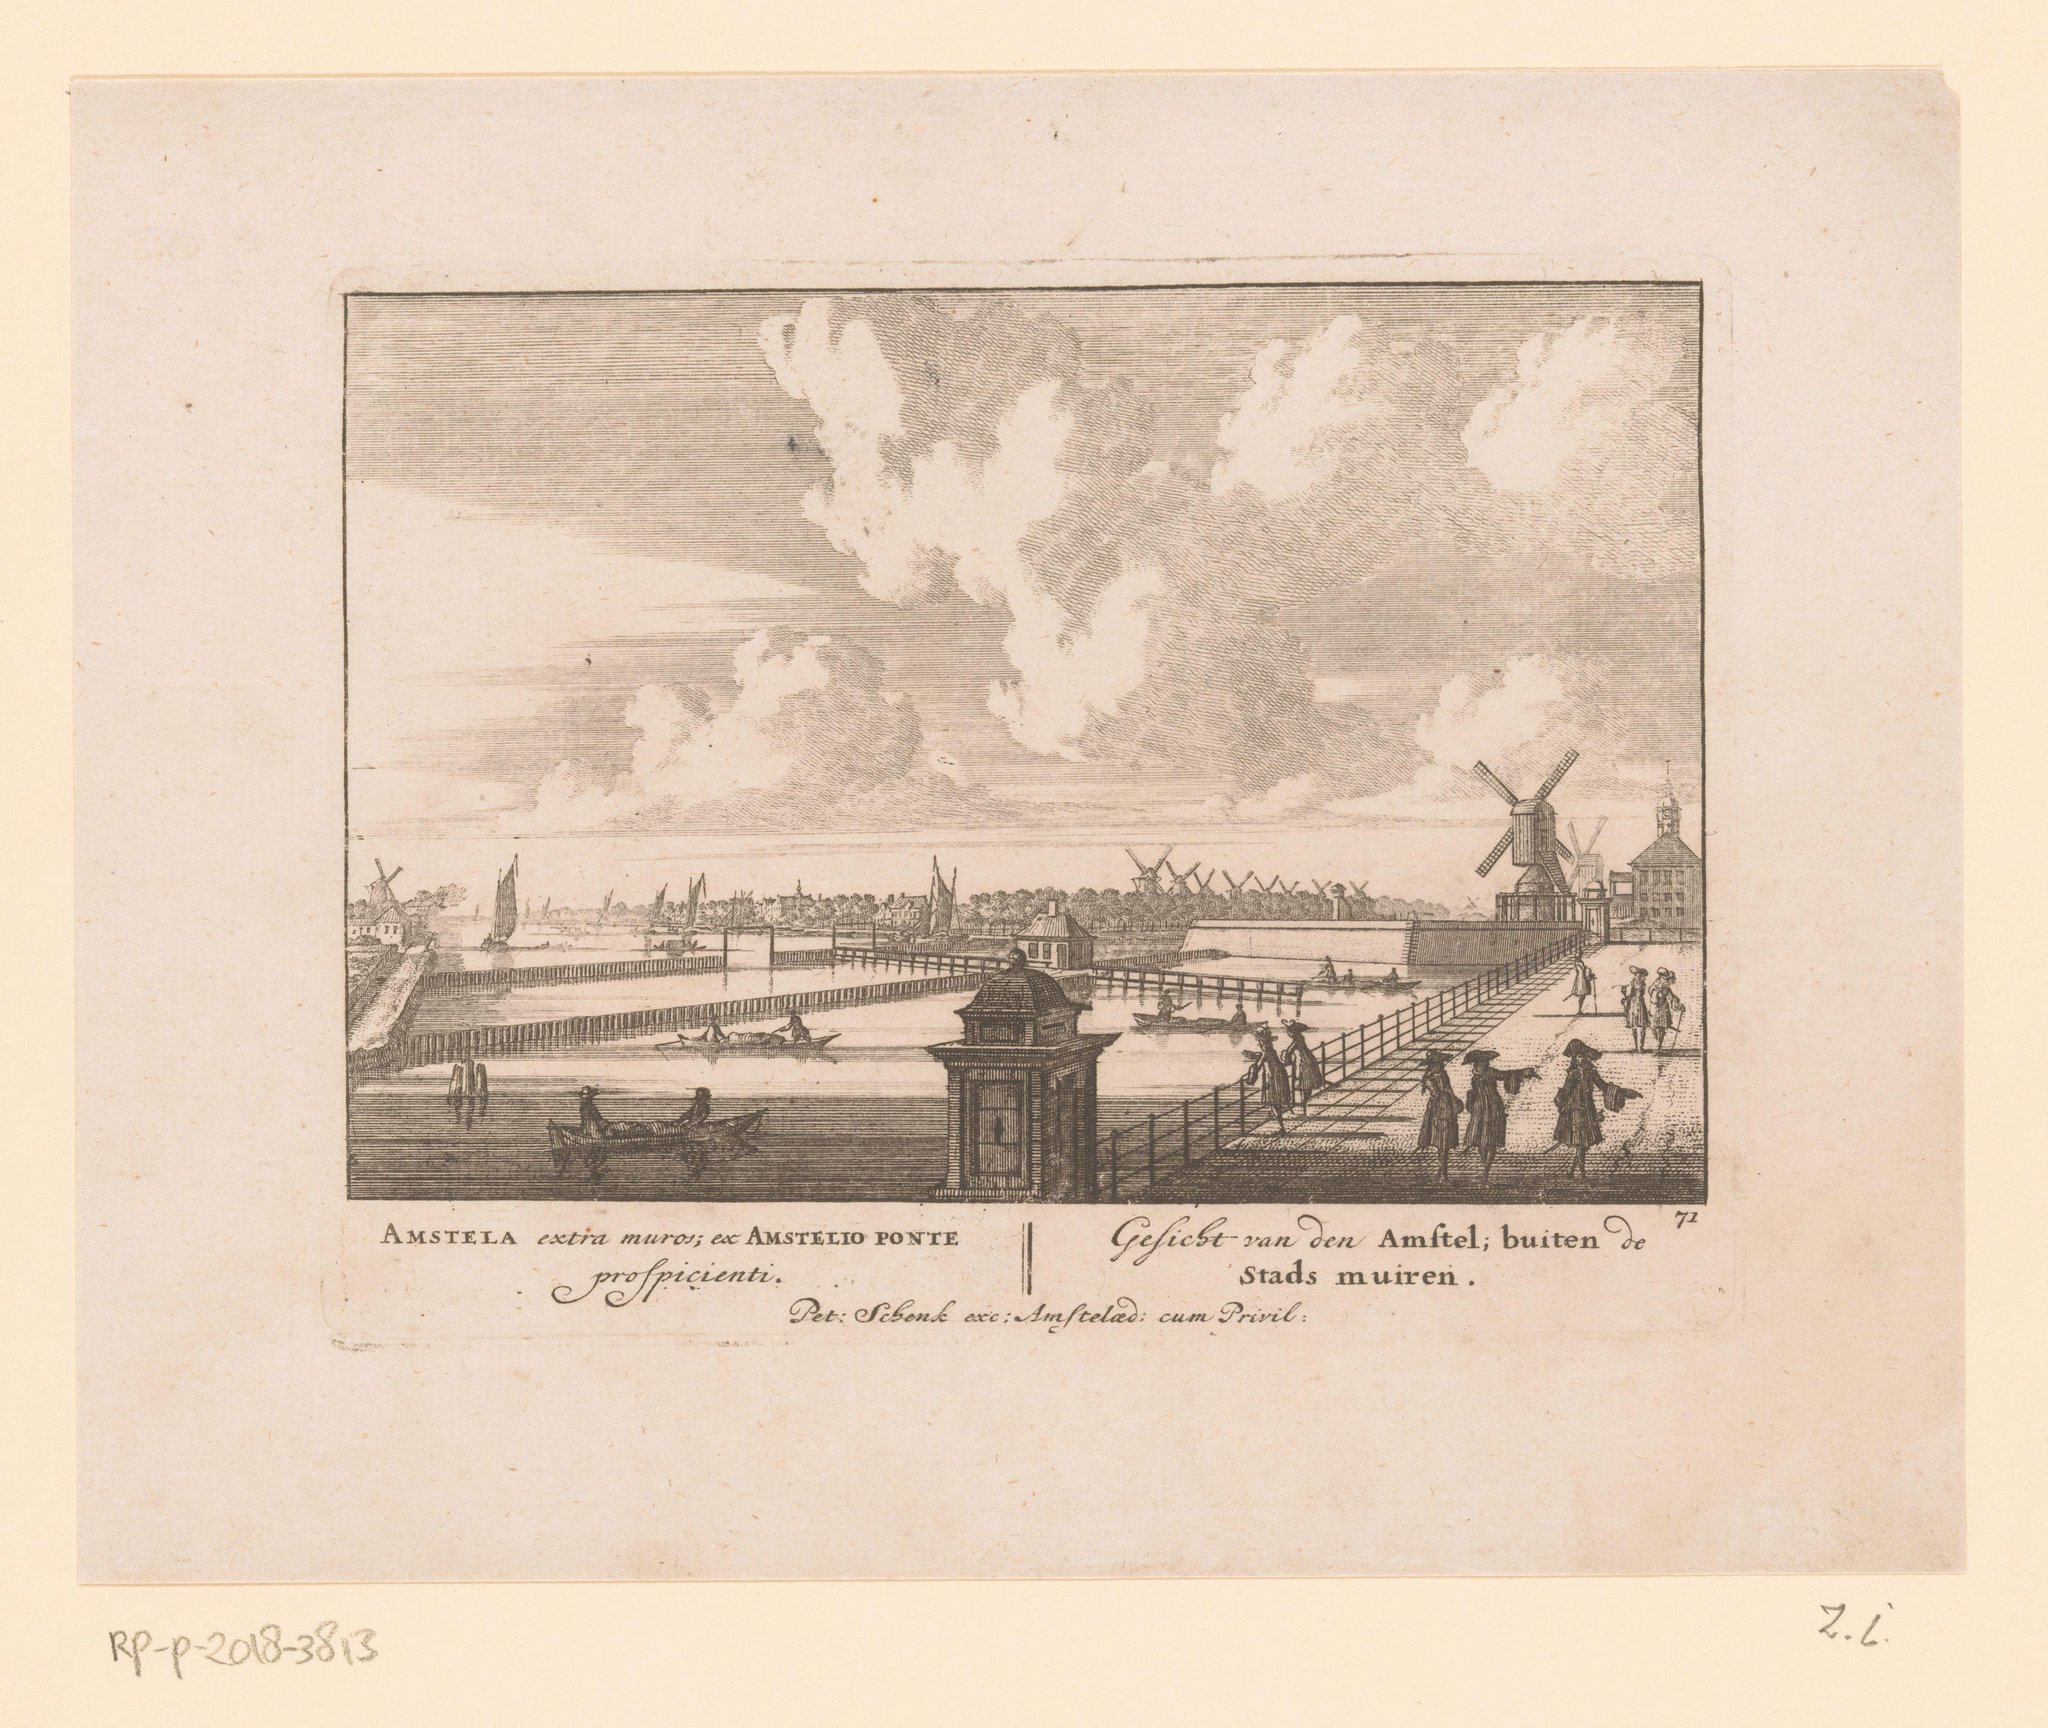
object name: print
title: Gezicht op de Hogesluis en de Amstel, met de Weesperzijde en de Utrechtsepoort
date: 1694-1697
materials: paper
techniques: etching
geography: amsterdam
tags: city-view, and landscape with man-made constructions, canals, waters (in city), bridge in city across river, canal, etc., windmill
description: Prent uit: Admirandorum Quadruplex Spectaculum. Amsterdam: Pieter Schenk (I), [1694-1697]. In Hollstein vermeld bij een serie van 100 prenten over Amsterdam, maar de prenten die in Hollstein worden genoemd zijn groter.